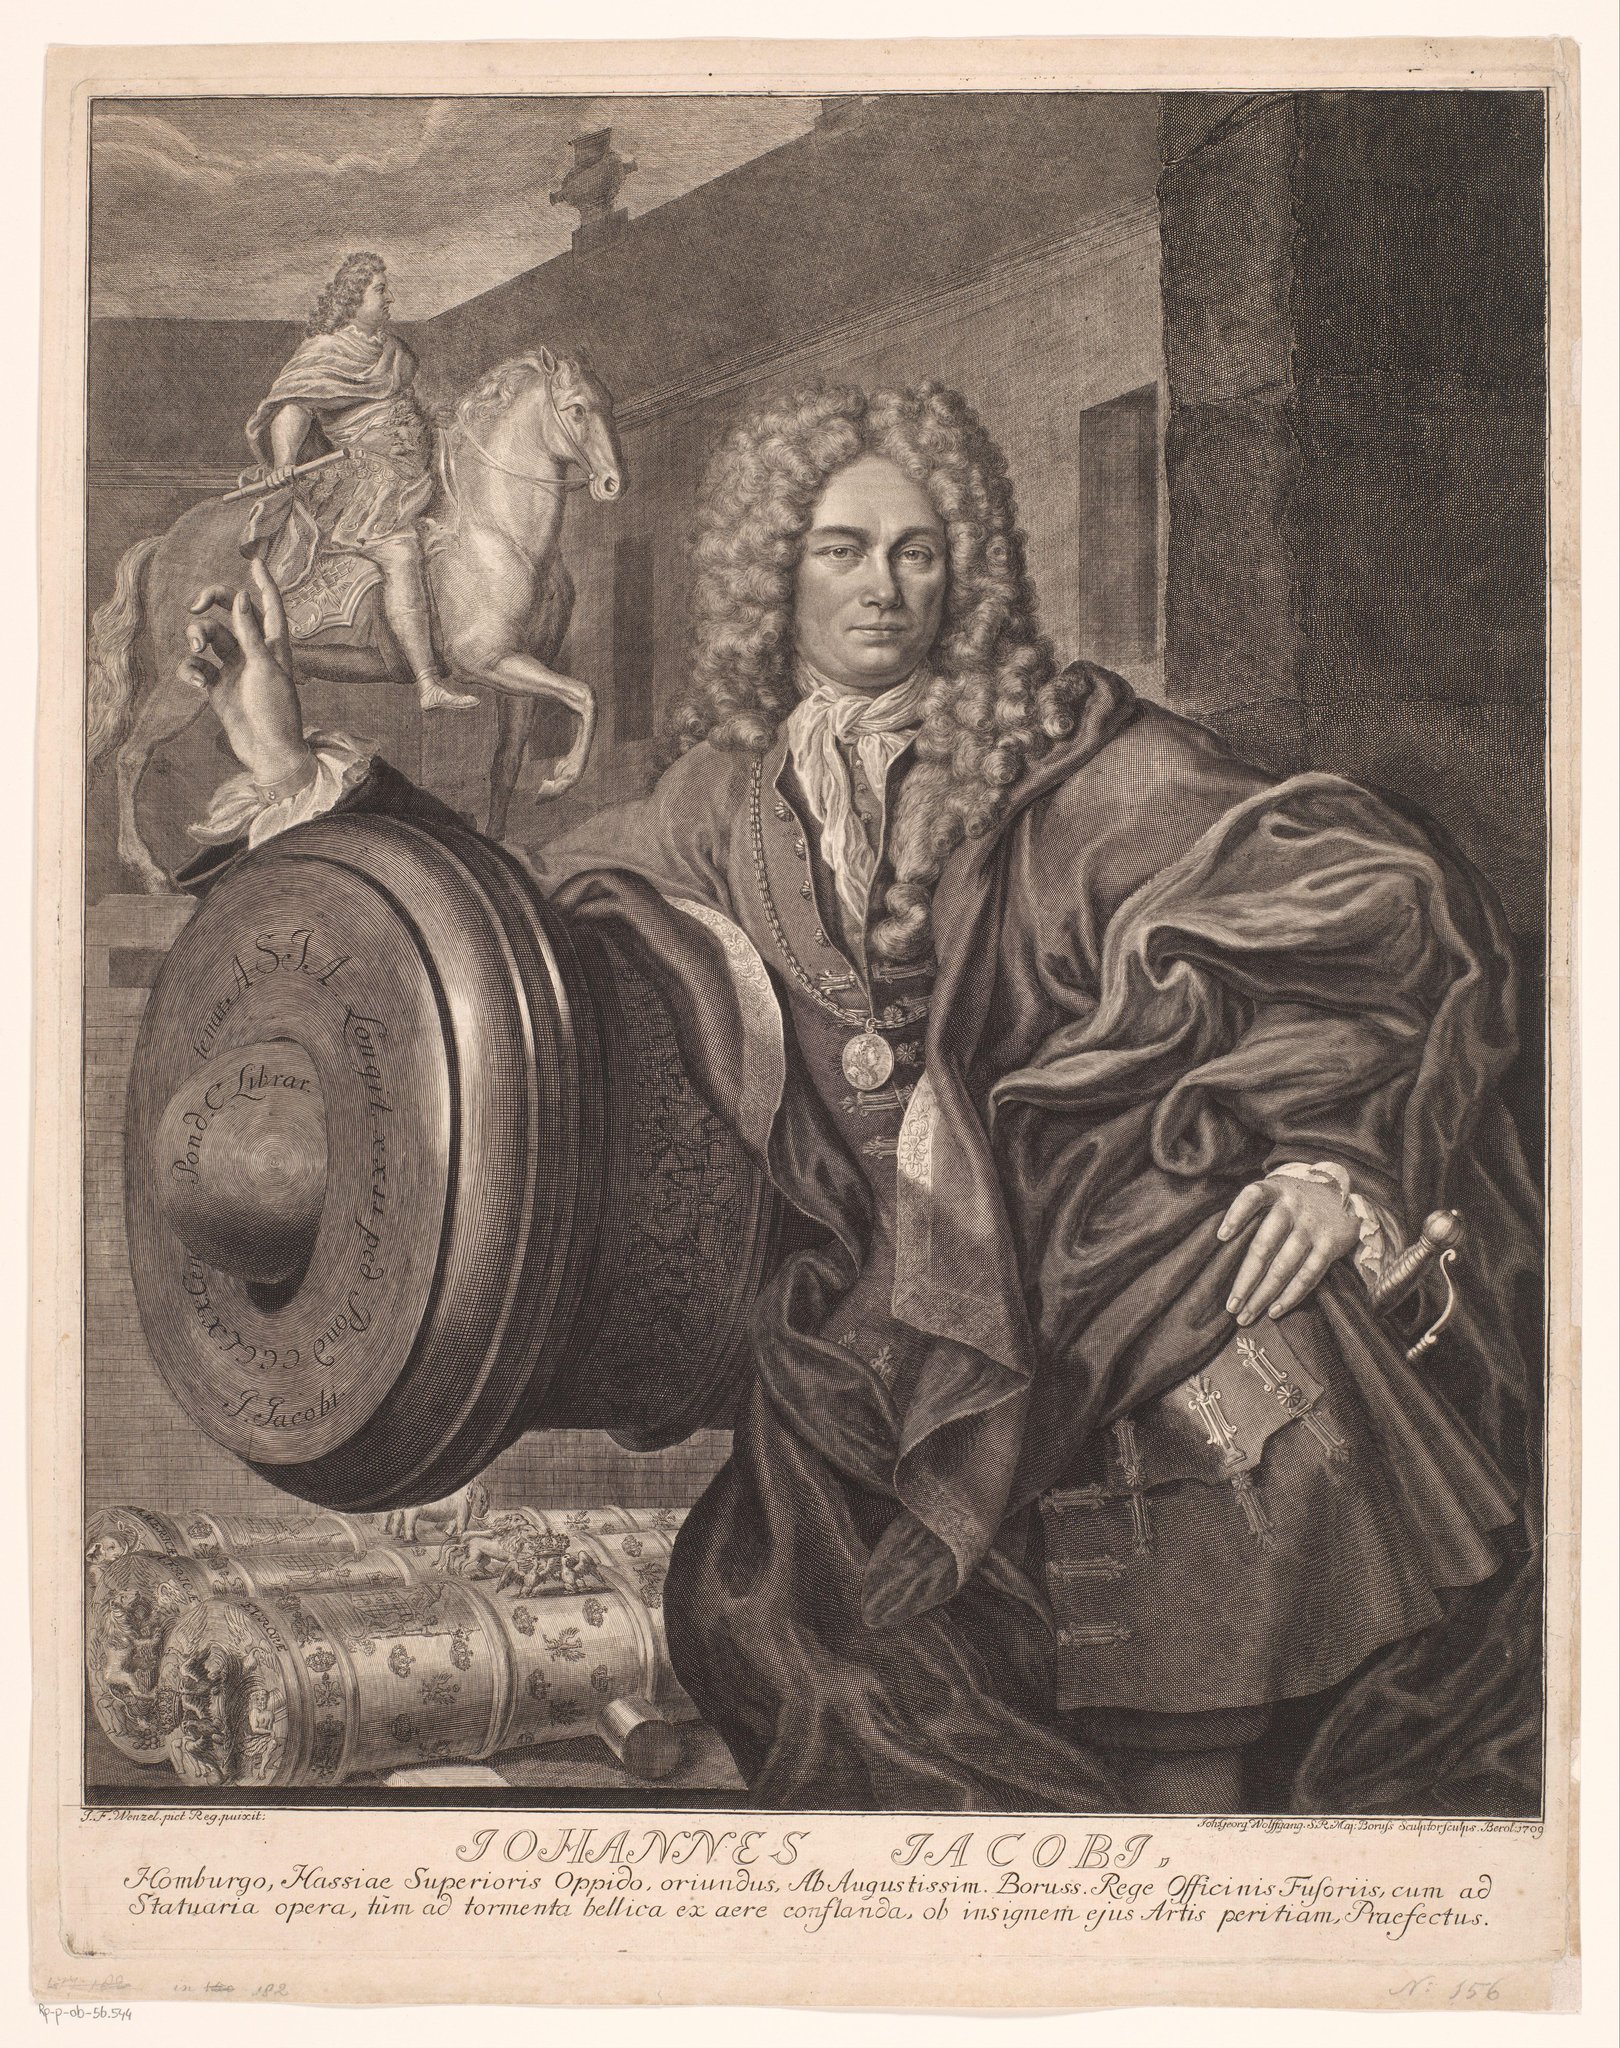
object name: print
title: Portret van Johannes Jacobi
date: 1709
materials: paper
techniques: engraving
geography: berlin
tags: berlin, caster, equestrian state-portrait, historical persons, firearms: cannon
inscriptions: collector's mark: Lugt 240